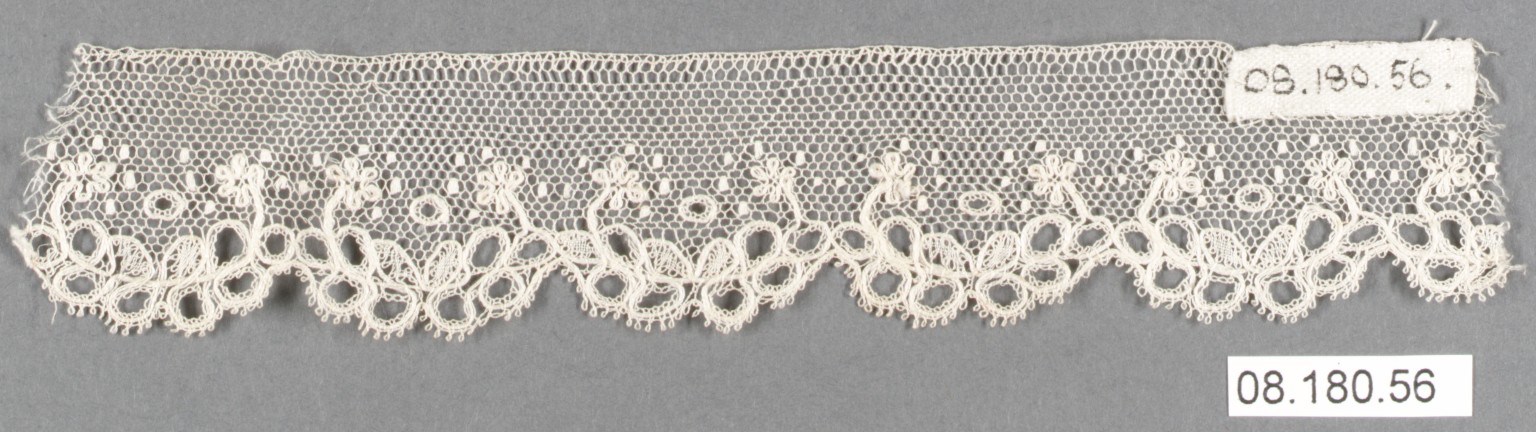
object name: baby lace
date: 1801-1900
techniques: lace